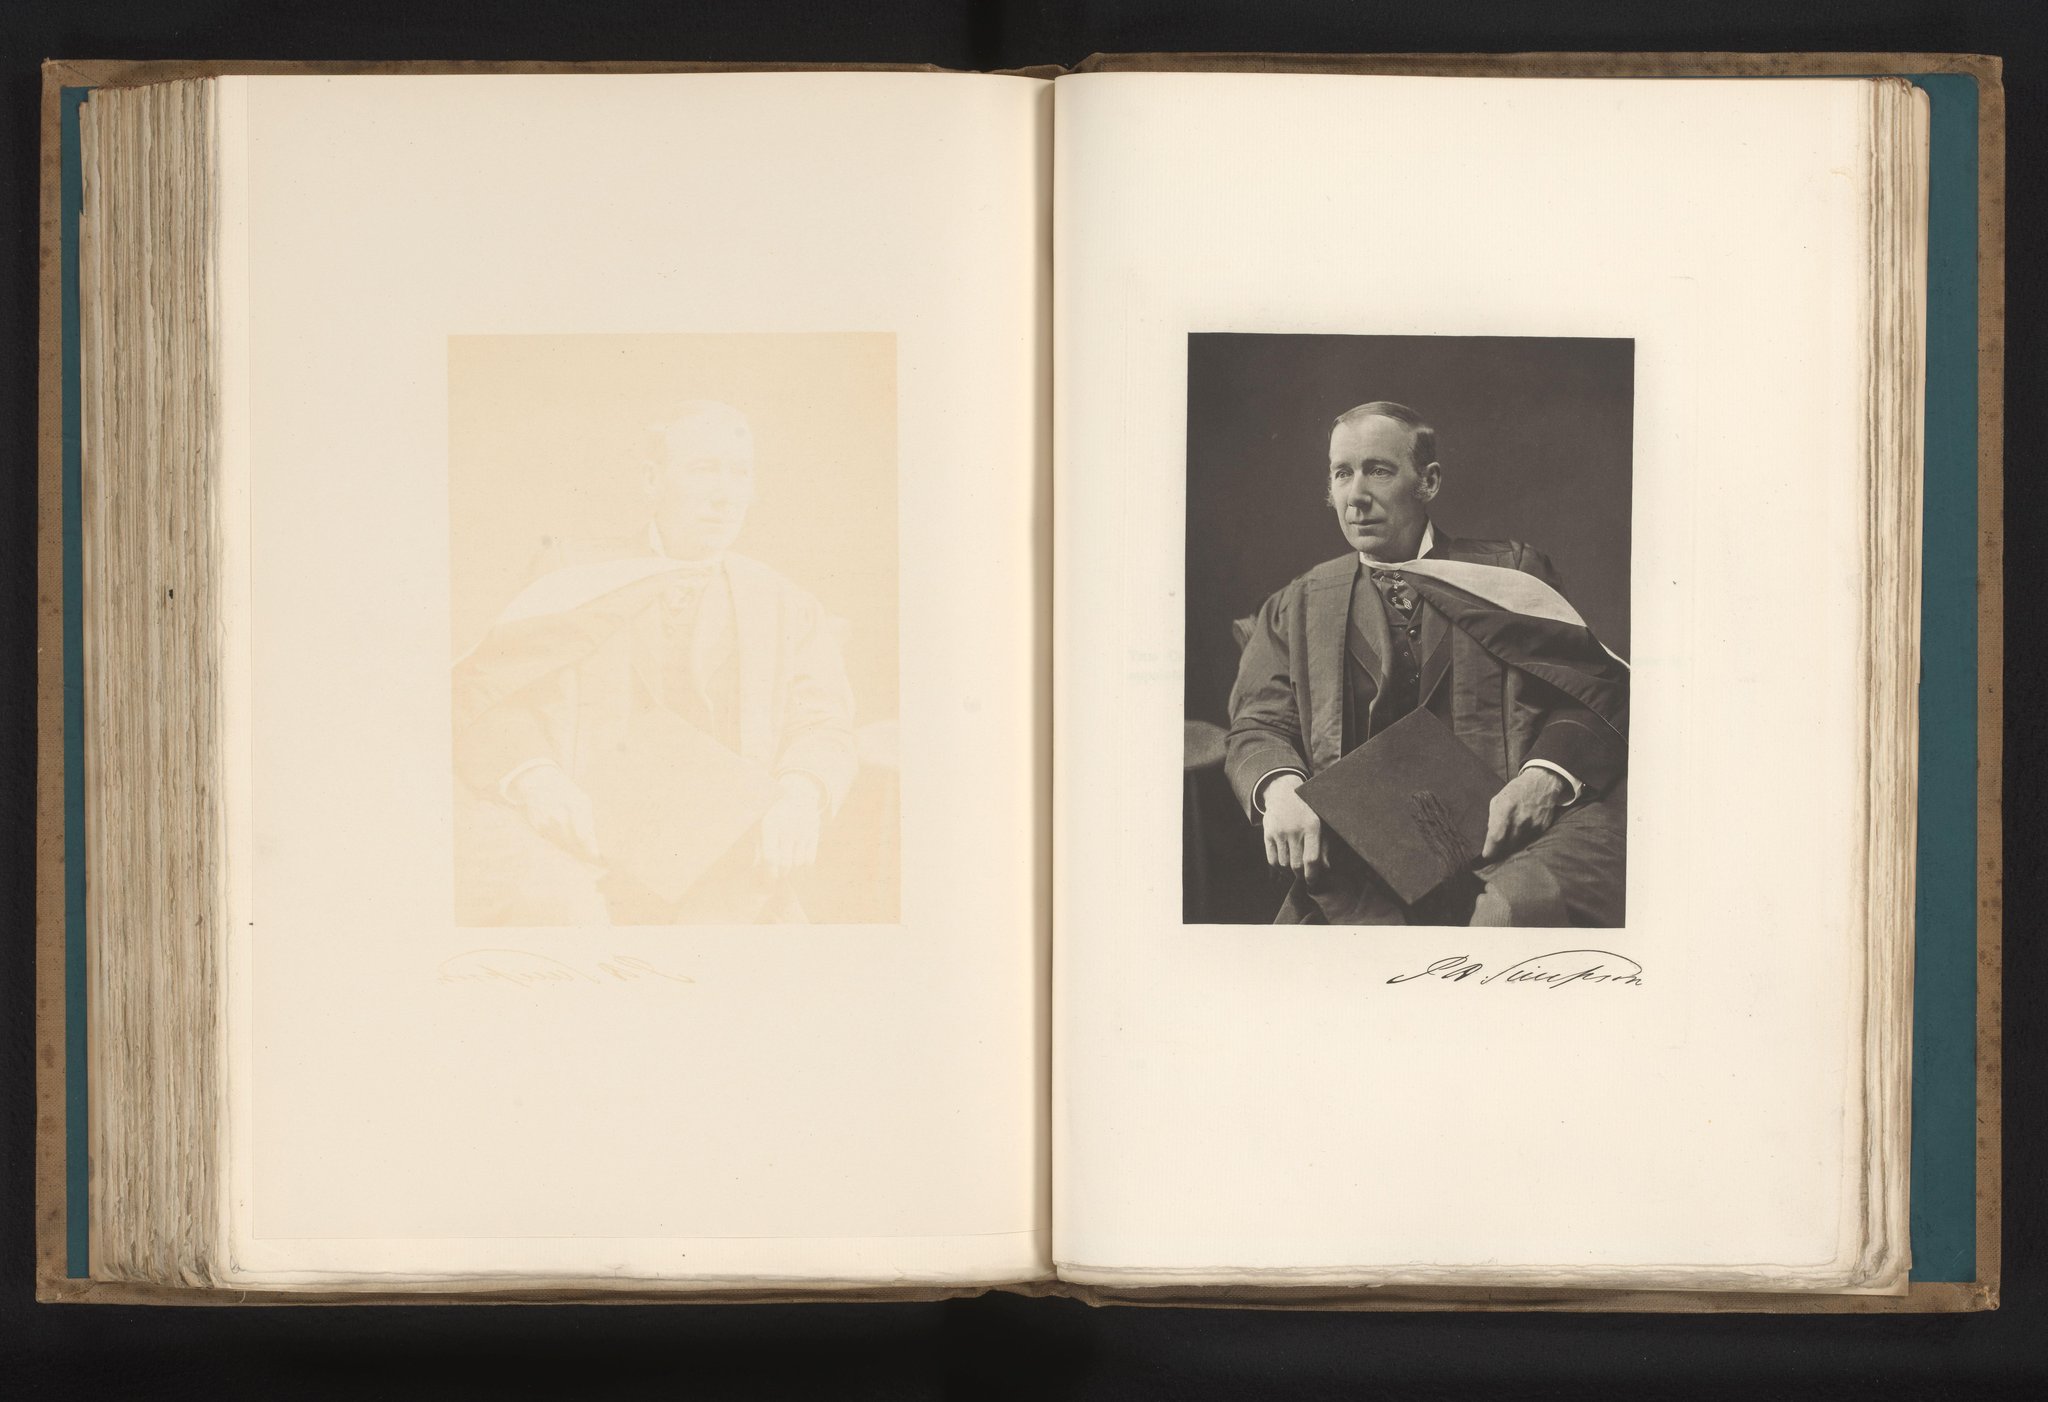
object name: photomechanical print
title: Portret van Pierce Adolphus Simpson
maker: Anonymous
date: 1886-1891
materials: paper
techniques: photoaquatint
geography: glasgow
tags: historical persons, physician, doctor, professor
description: Prent op negende ongenummerde pagina na pagina 128.